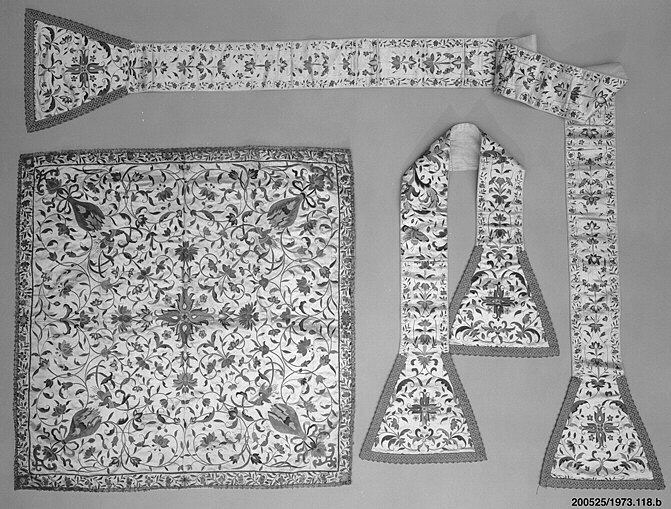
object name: maniple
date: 1767-1800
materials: silk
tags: flowers,leaves